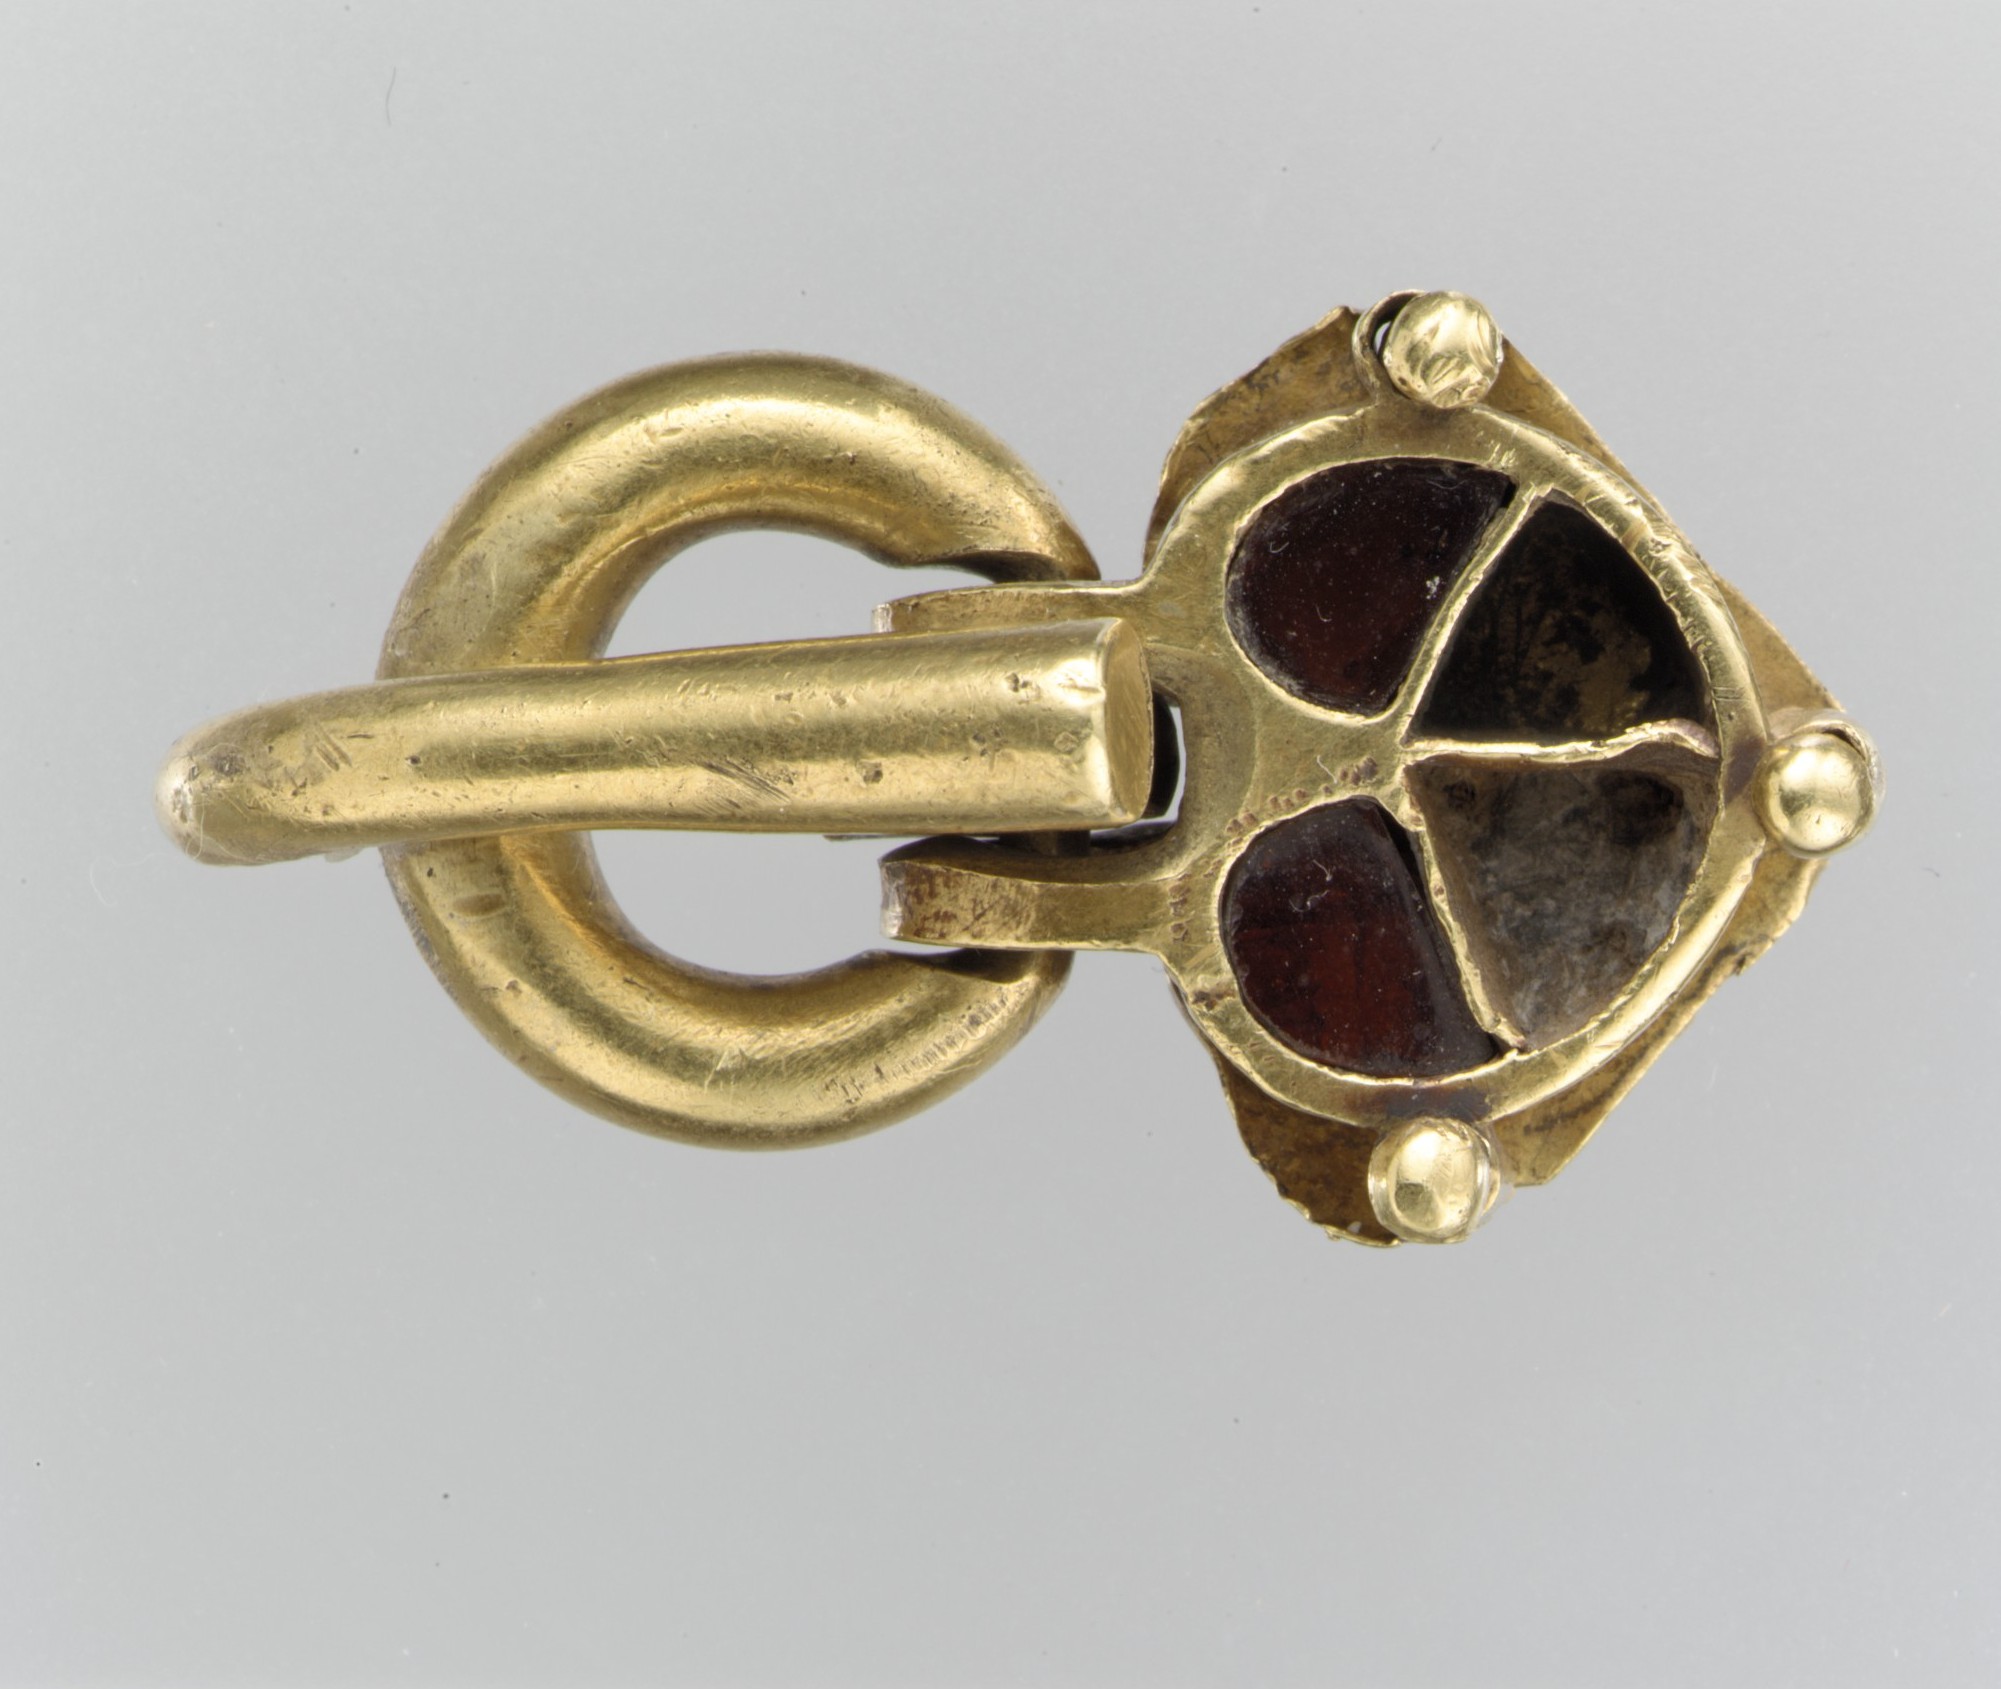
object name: shoe buckle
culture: frankish or hunnic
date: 400-450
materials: garnet, gold